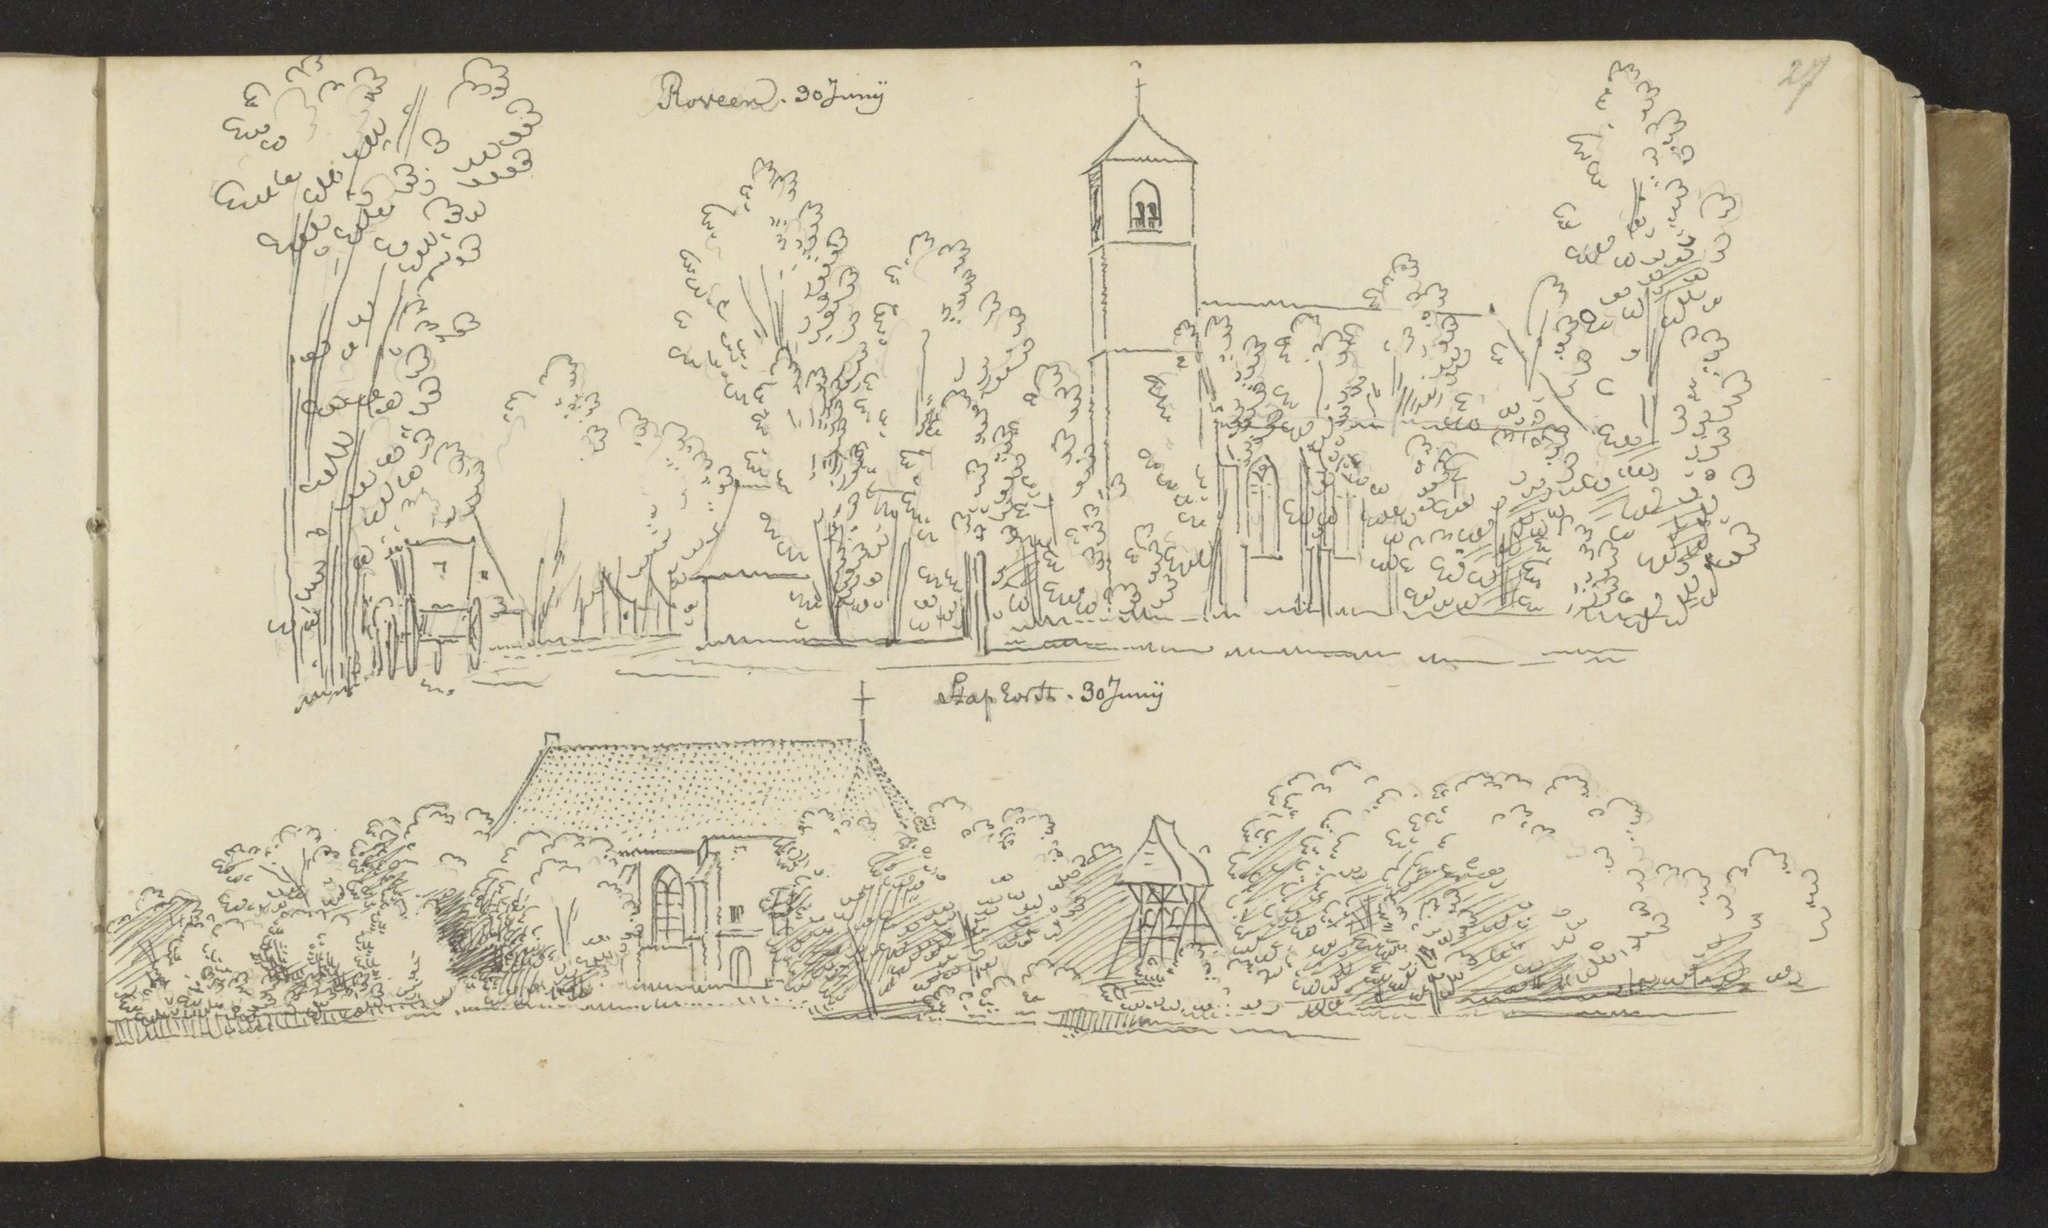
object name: sketchbook leaf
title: Gezichten op Rouveen en Staphorst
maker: abraham de haen (ii)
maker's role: draughtsman, print maker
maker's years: 1707-1748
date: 1732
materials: ink, paper, pencil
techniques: pen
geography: staphorst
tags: village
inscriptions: date and inscription: ‘Roveen.30 junij/ Staphorst.30 junij’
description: Blad 27 recto uit een schetsboek met 51 bladen.